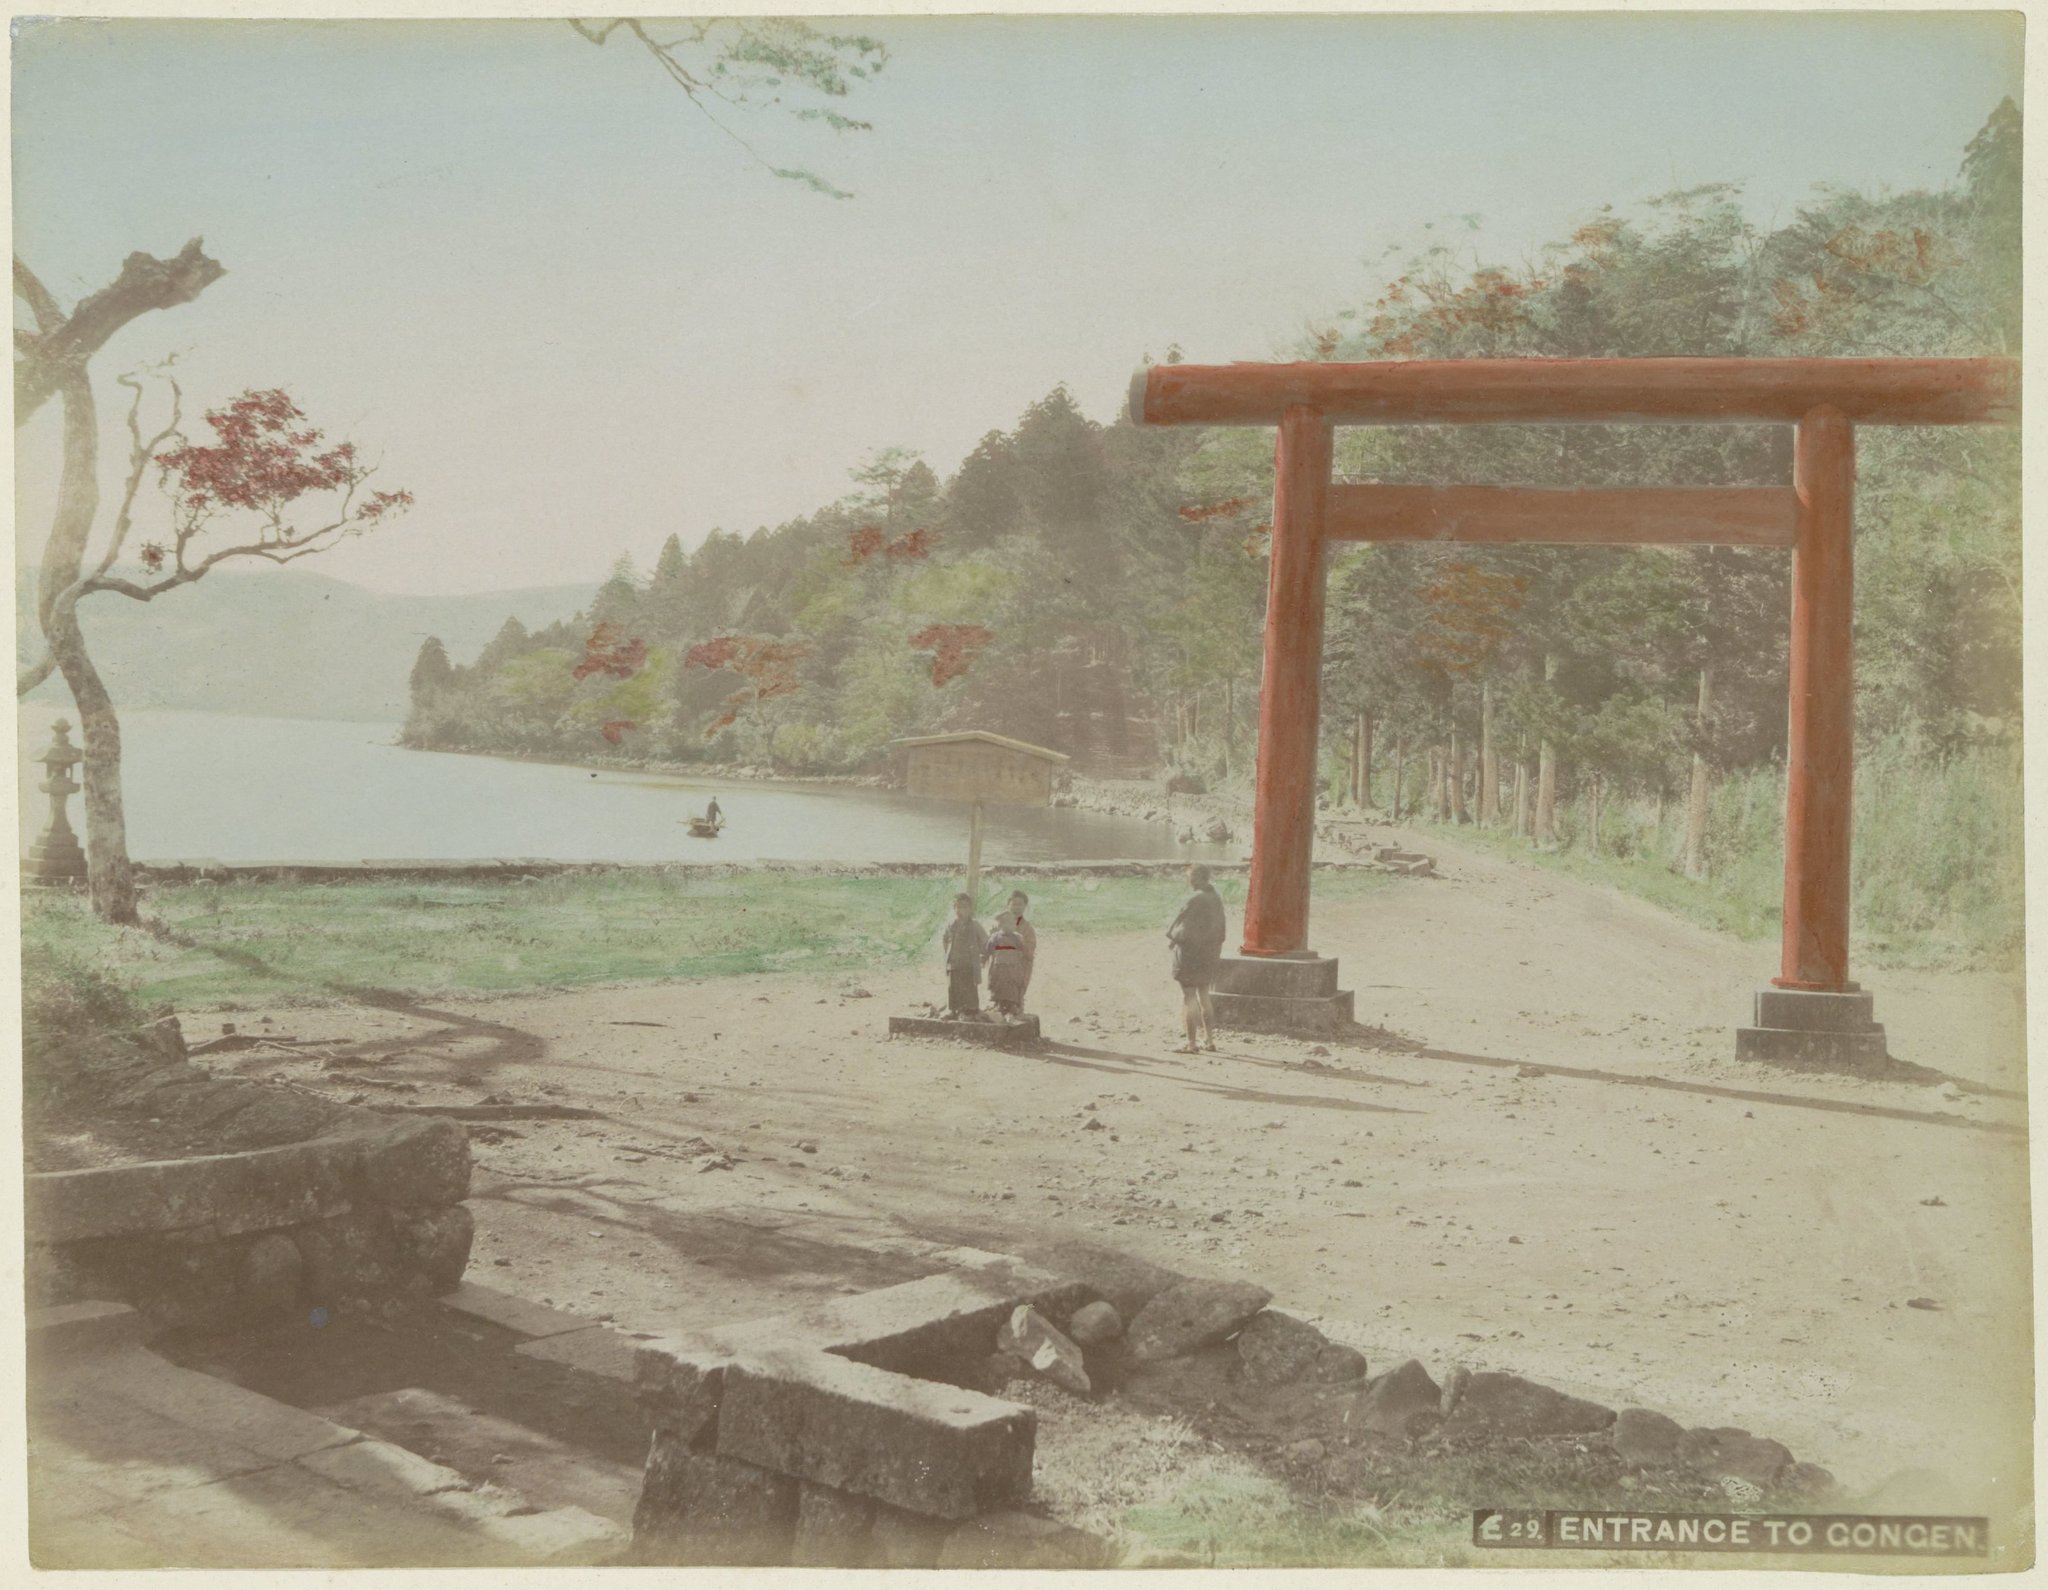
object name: photograph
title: Entrance to Gongen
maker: Anonymous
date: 1870-1900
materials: cardboard, paper, photographic support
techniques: albumen print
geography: hakone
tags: lake, gate, entrance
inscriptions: negative number: ‘E 29’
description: Onderdeel van Reisalbum met foto's van bezienswaardigheden in Japan.